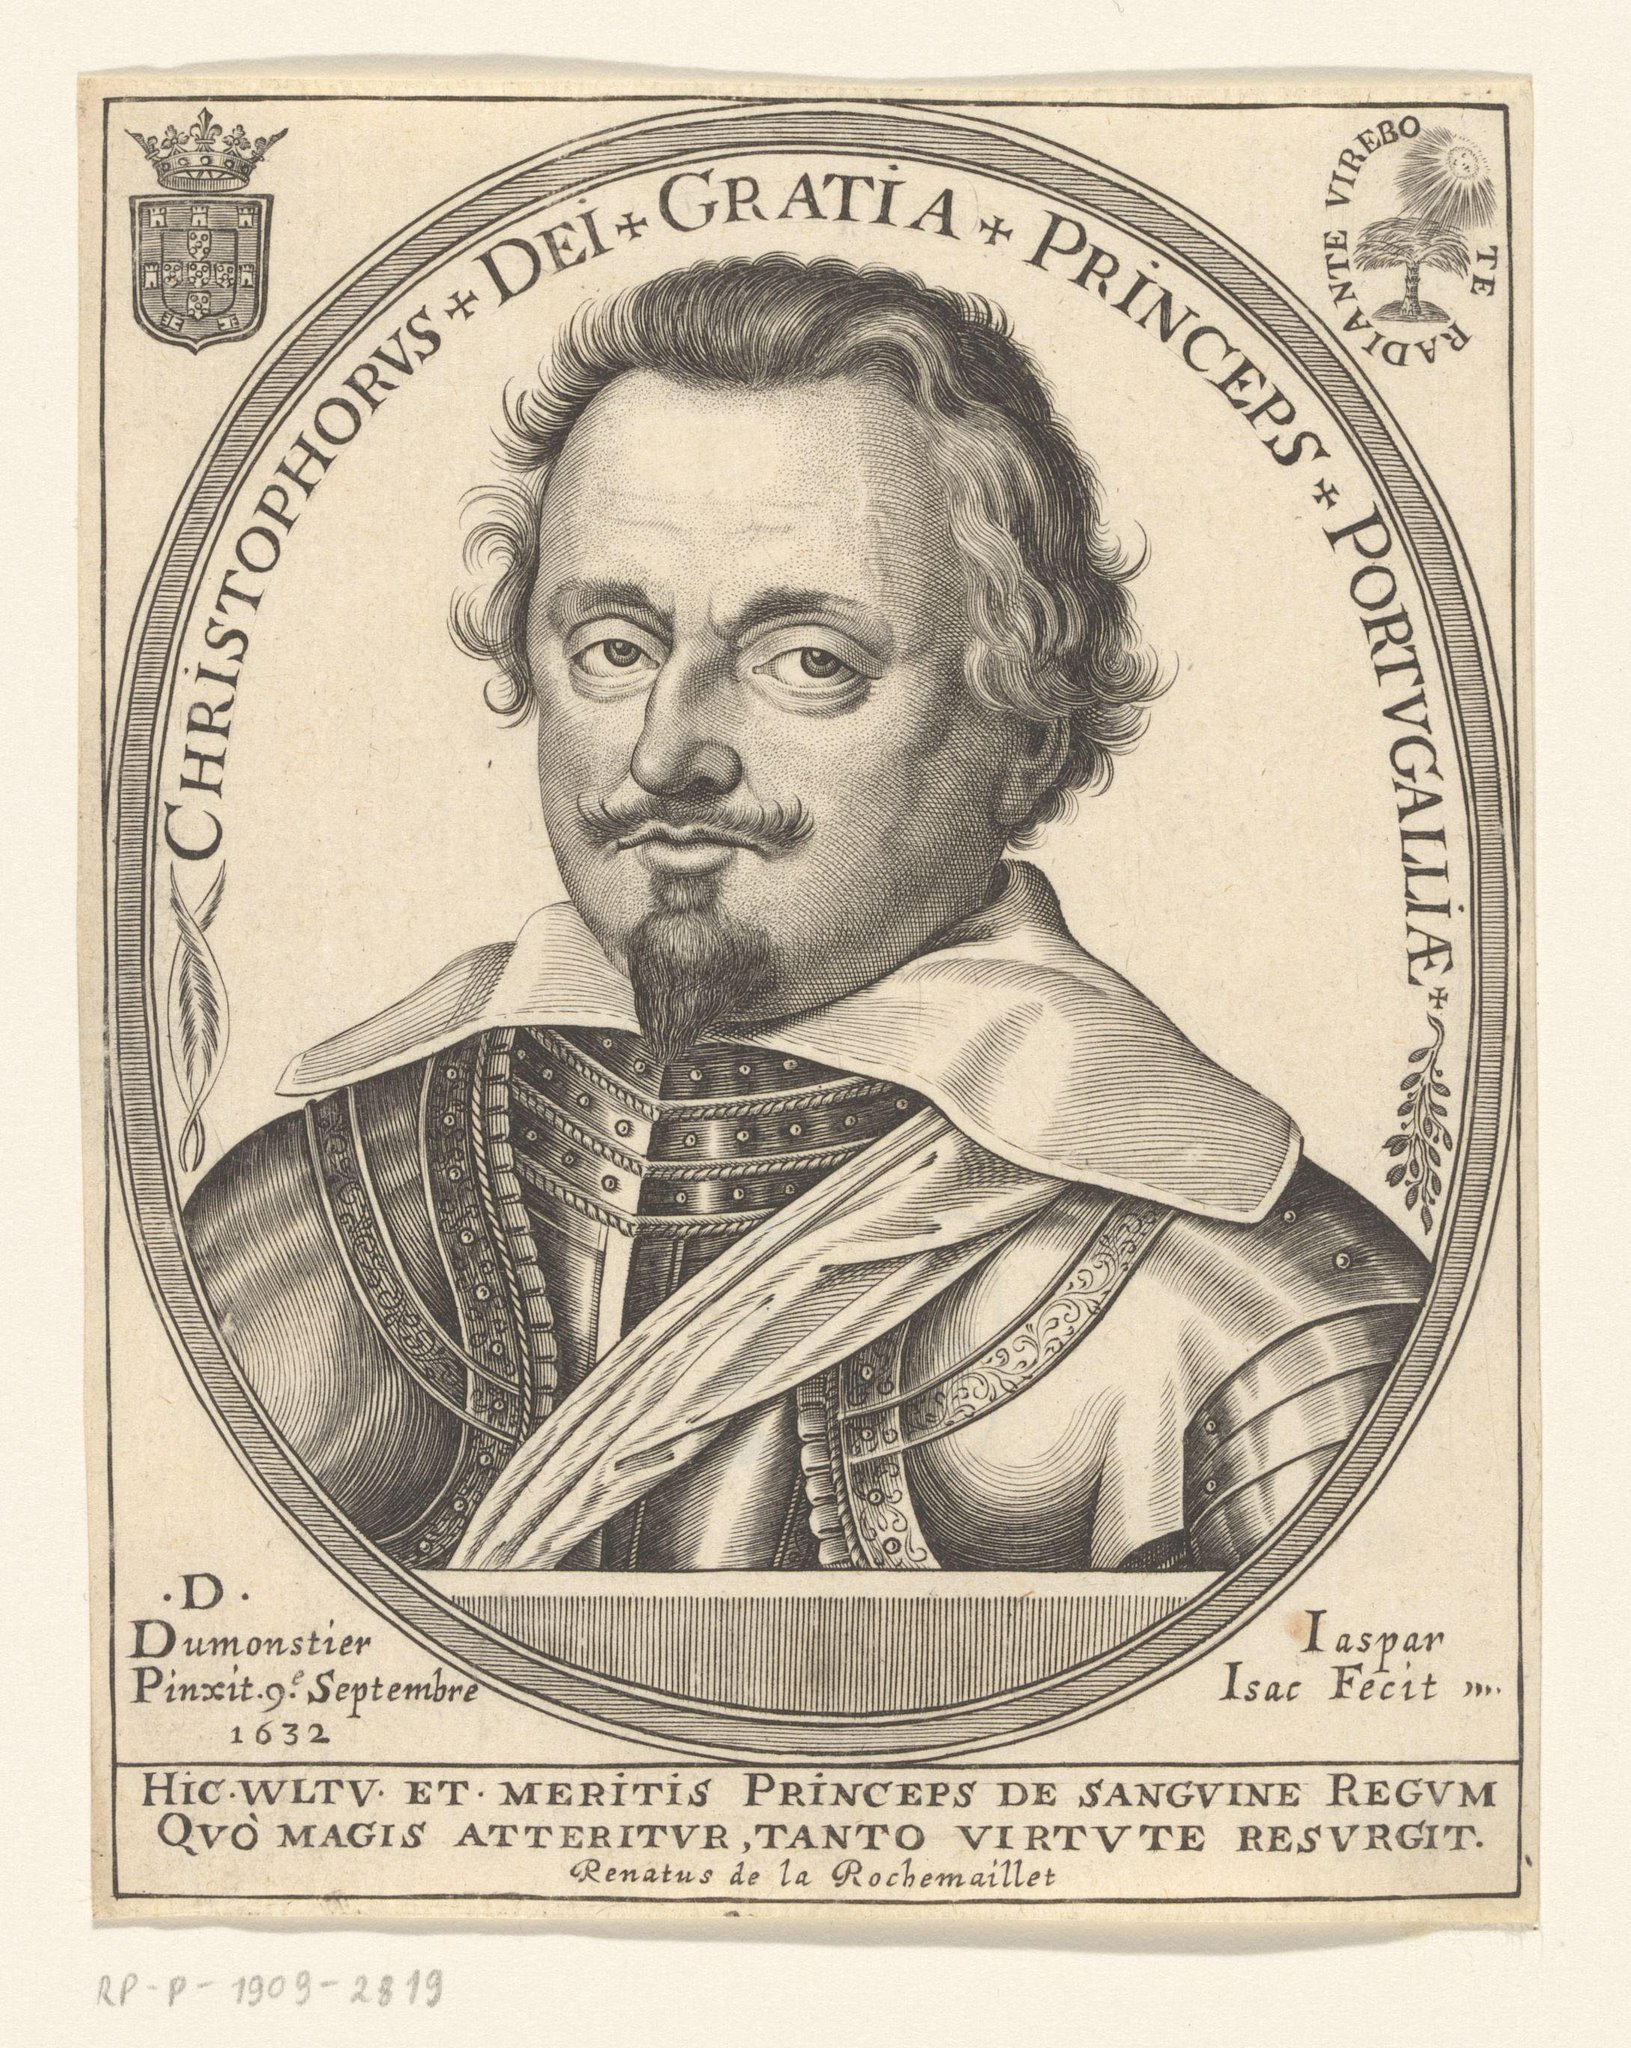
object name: print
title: Portret van Christoffel van Portugal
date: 1632-1654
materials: paper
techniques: engraving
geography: france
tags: ornament ~ medallion, prince, historical persons, armorial bearing, heraldry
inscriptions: collector's mark: Lugt 2228, collector's mark: Lugt 2773